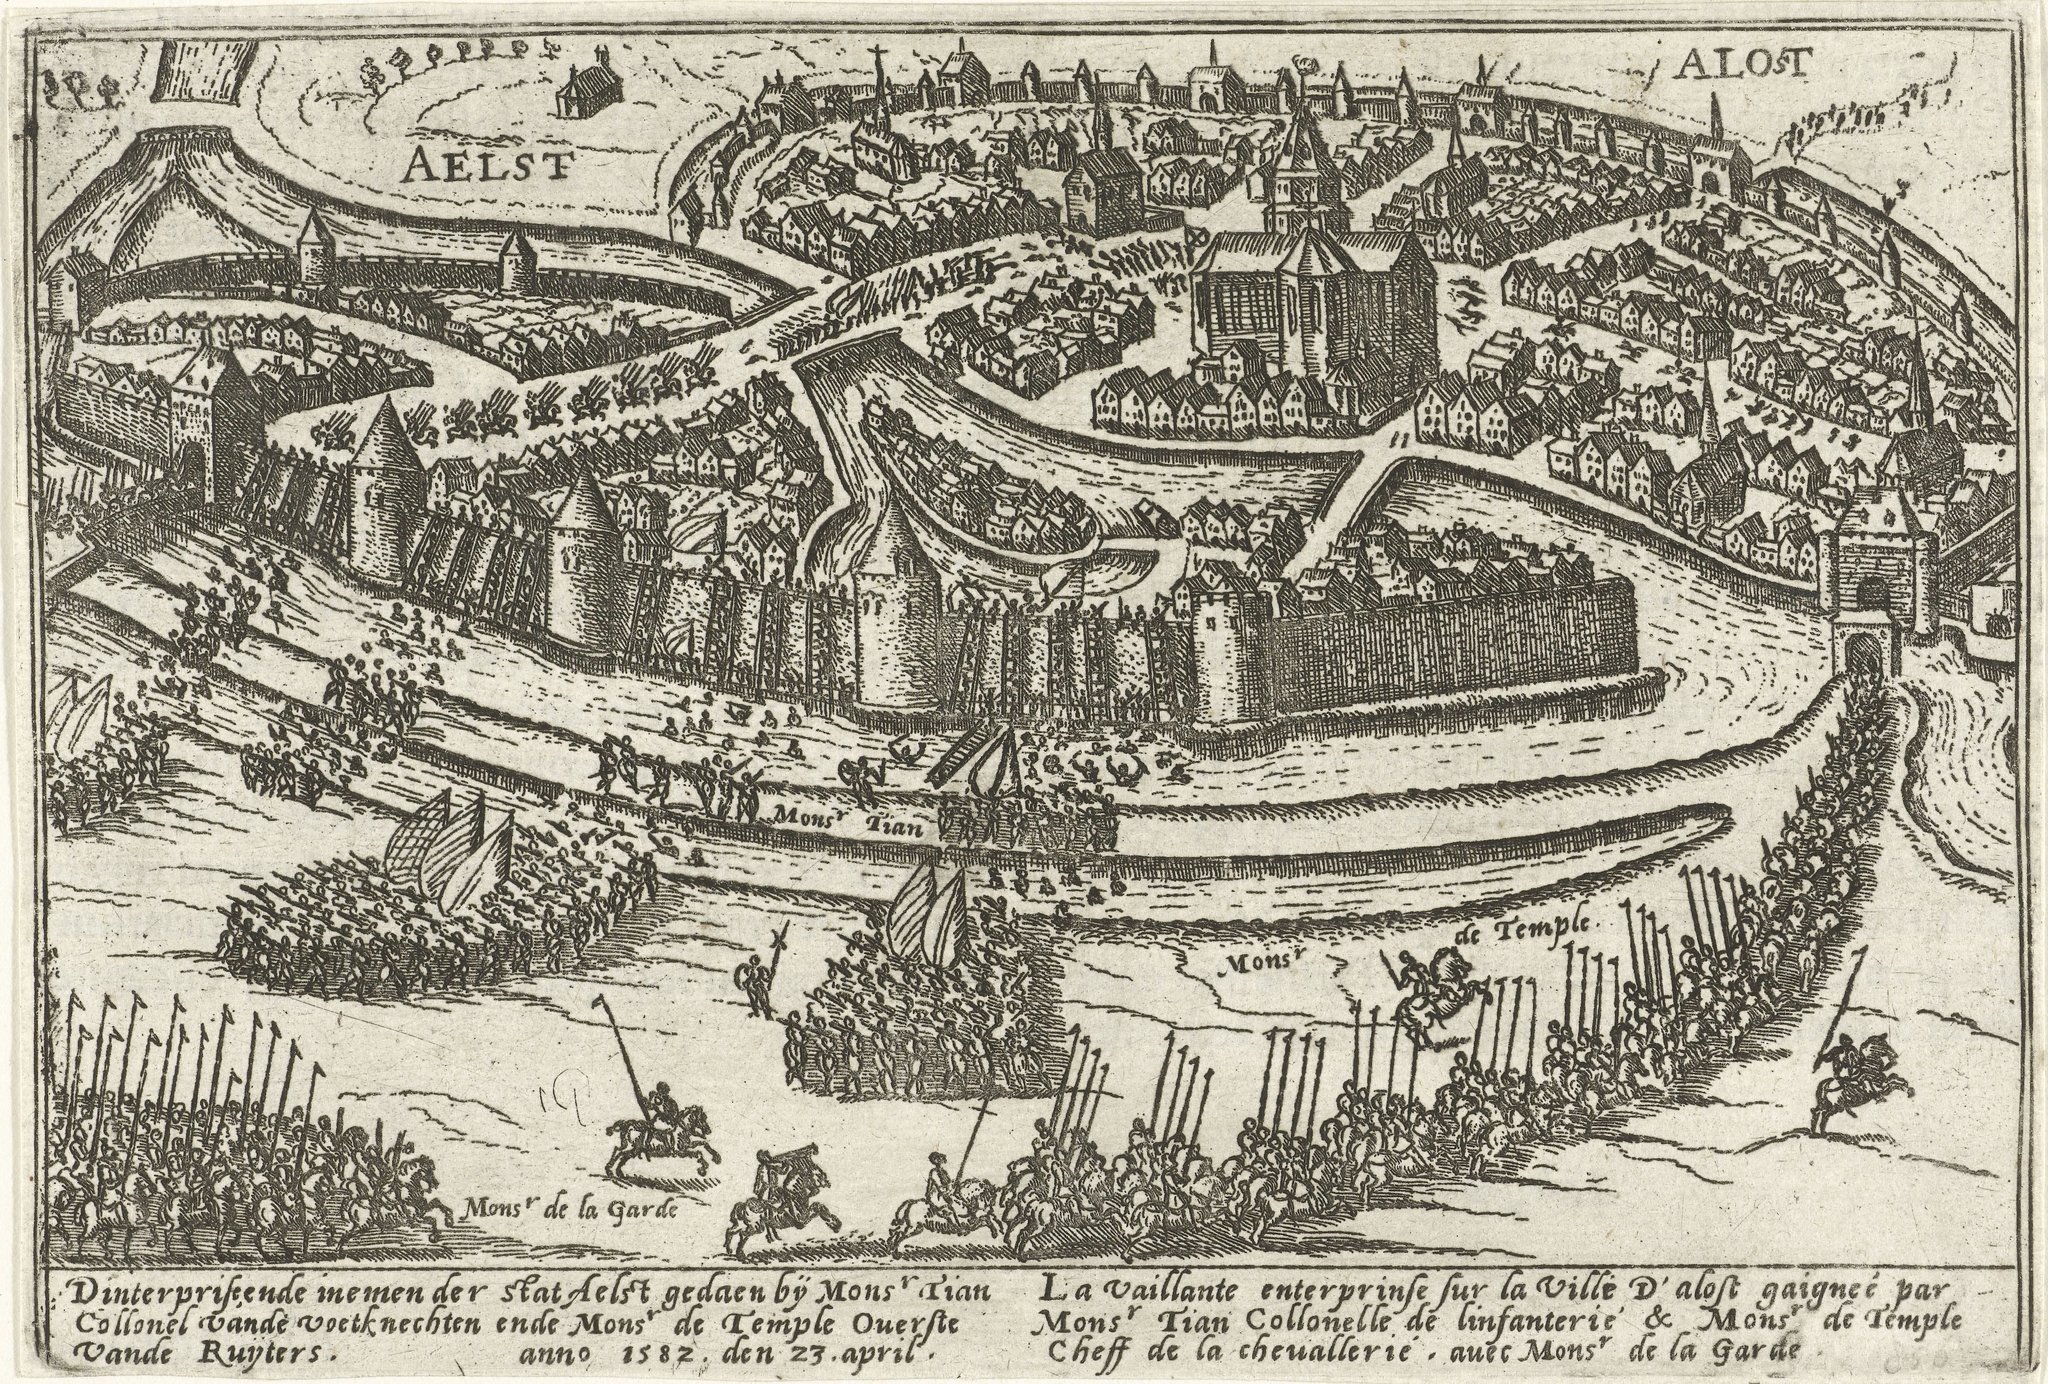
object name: history print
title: Inname van Aalst, 1582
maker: Anonymous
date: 1613-1615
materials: paper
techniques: etching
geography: northern netherlands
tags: capture of city (after the siege)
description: Inname van Aalst door het leger van de hertog van Parma, 23 april 1582. Met onderschrift van 3 regels in het Nederlands en 3 regels in het Frans. Ongenummerd. Bedrukt op achterzijde met tekst in het Latijn.